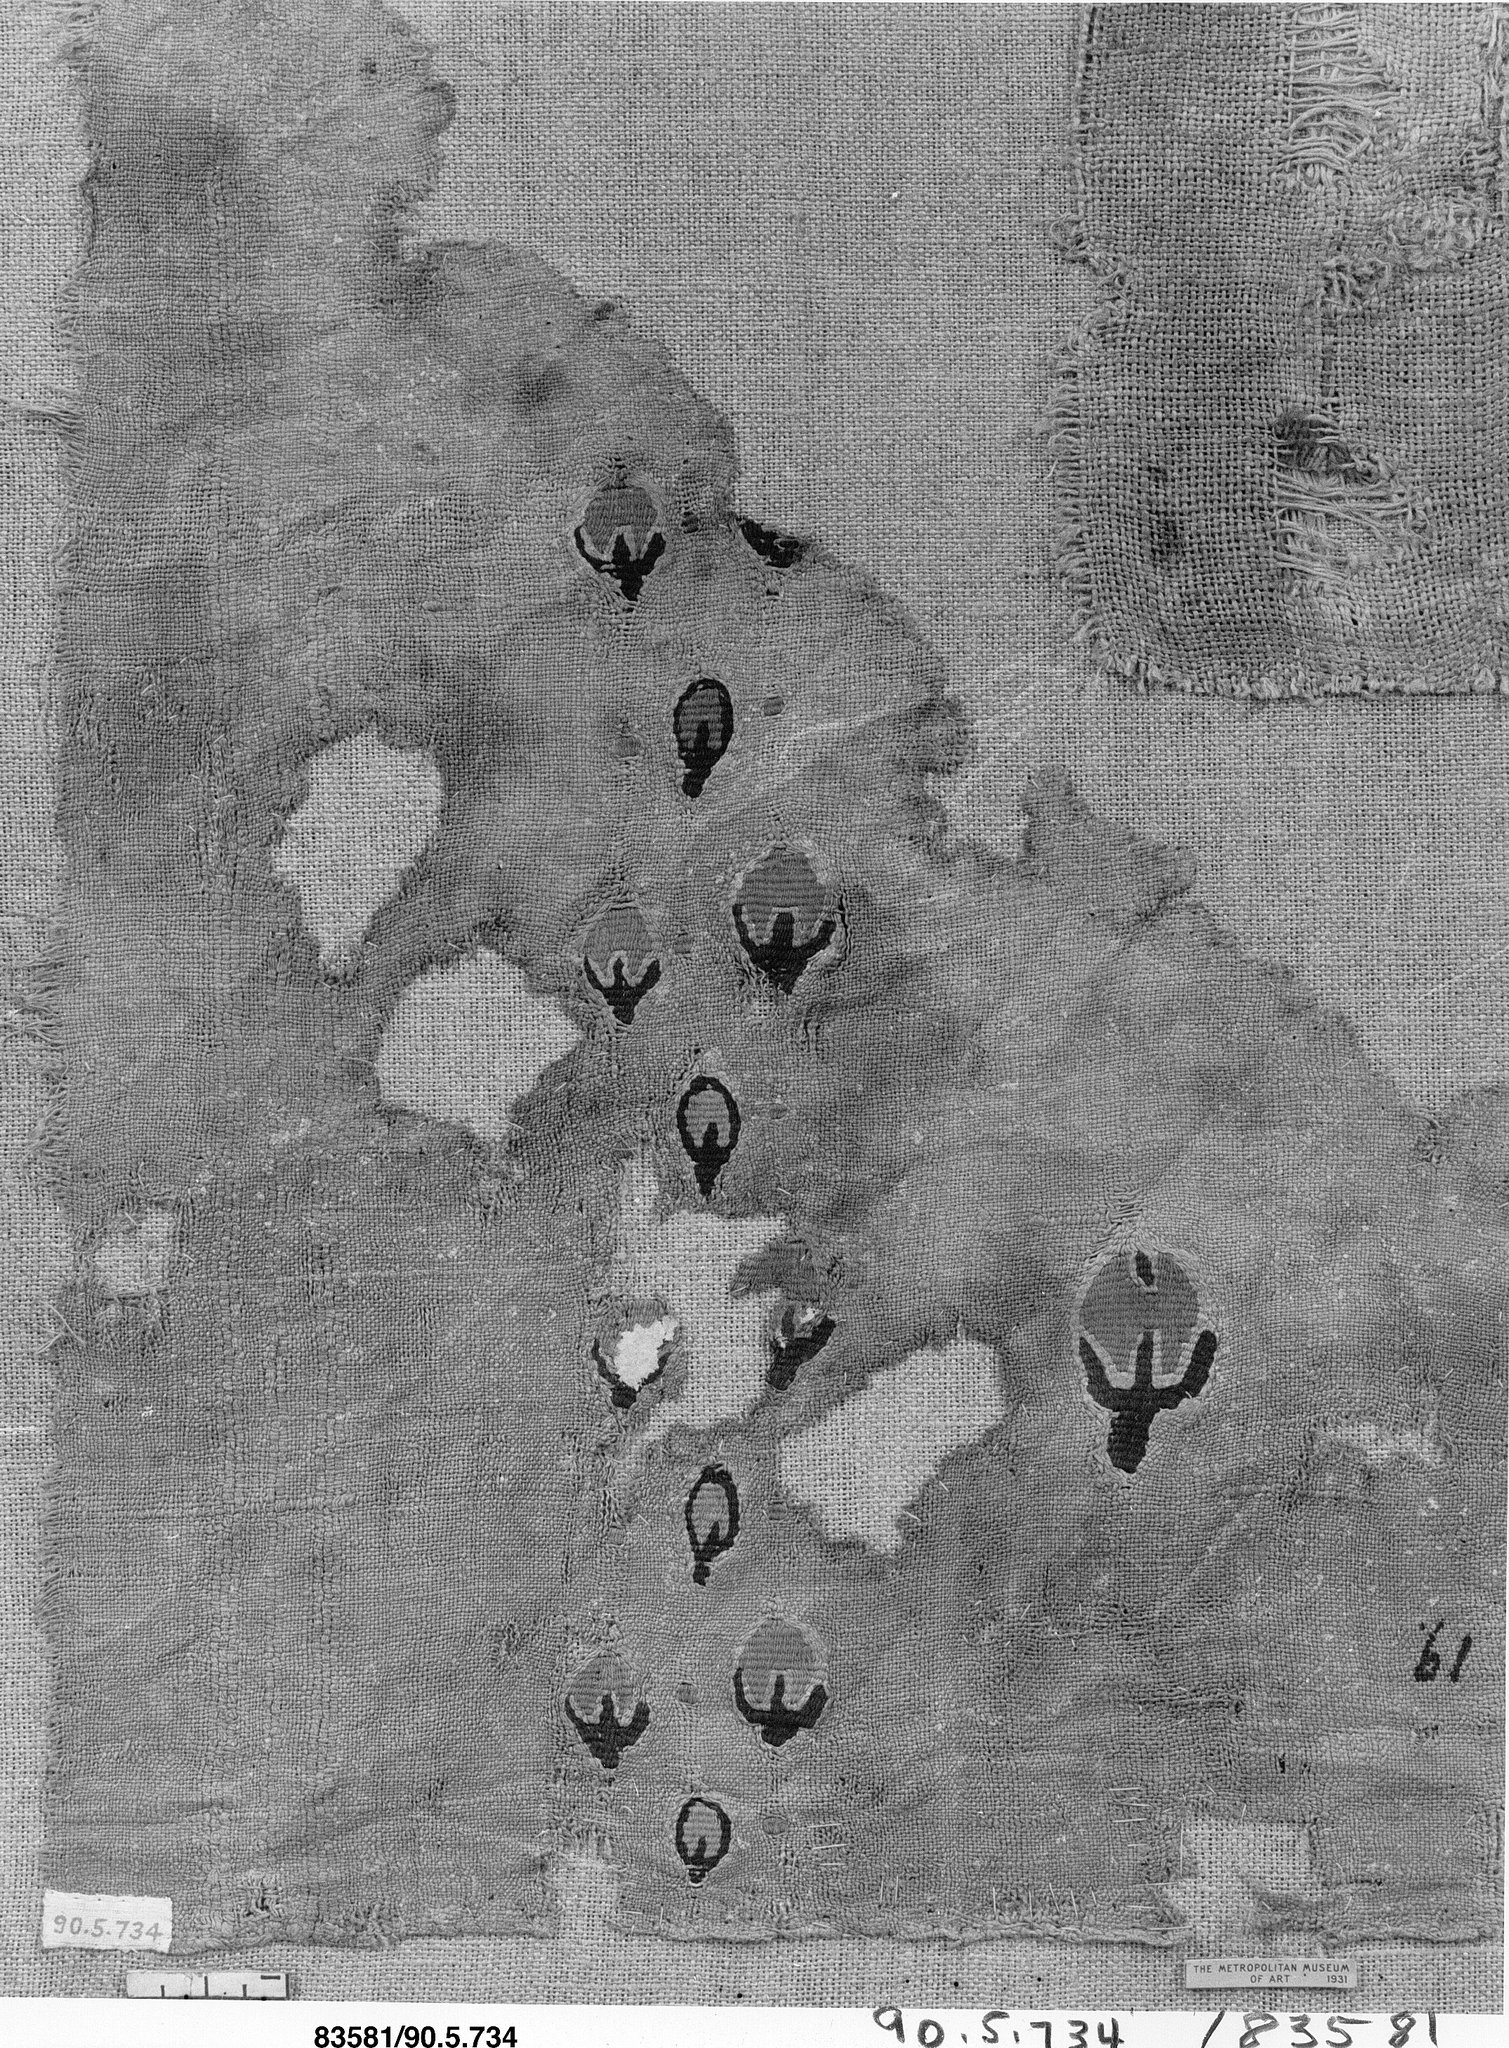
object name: textile fragment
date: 401-500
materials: linen, wool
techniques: weave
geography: egypt